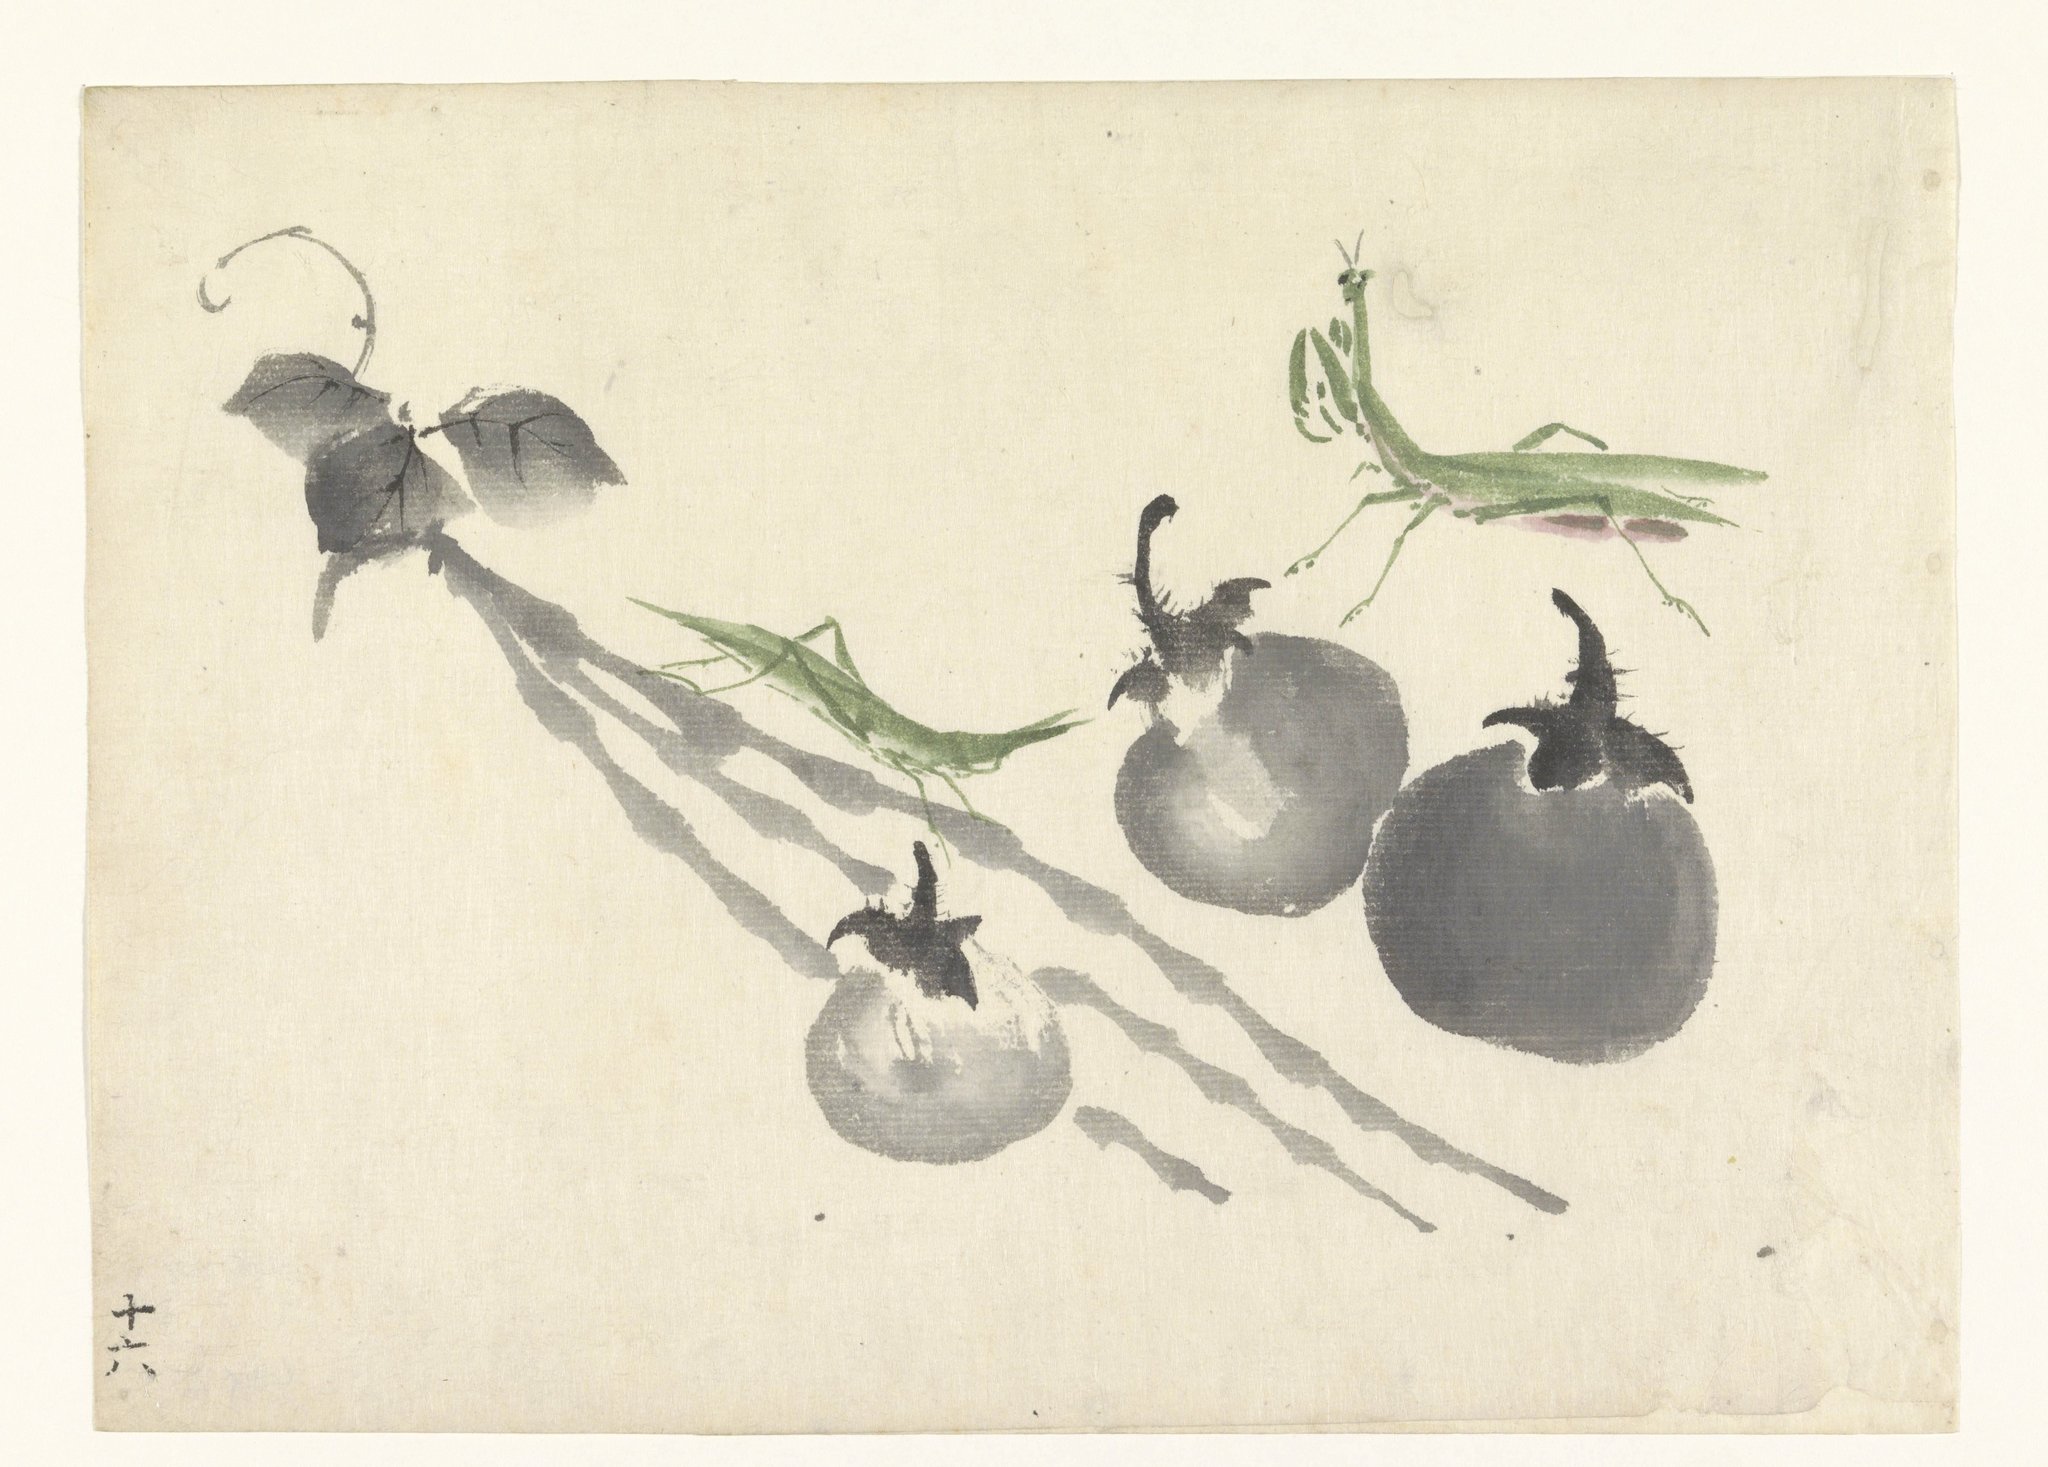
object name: drawing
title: Sprinkhanen bij drie kaki's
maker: Anonymous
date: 1800-1899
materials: paper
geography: japan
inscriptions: number: ‘16’